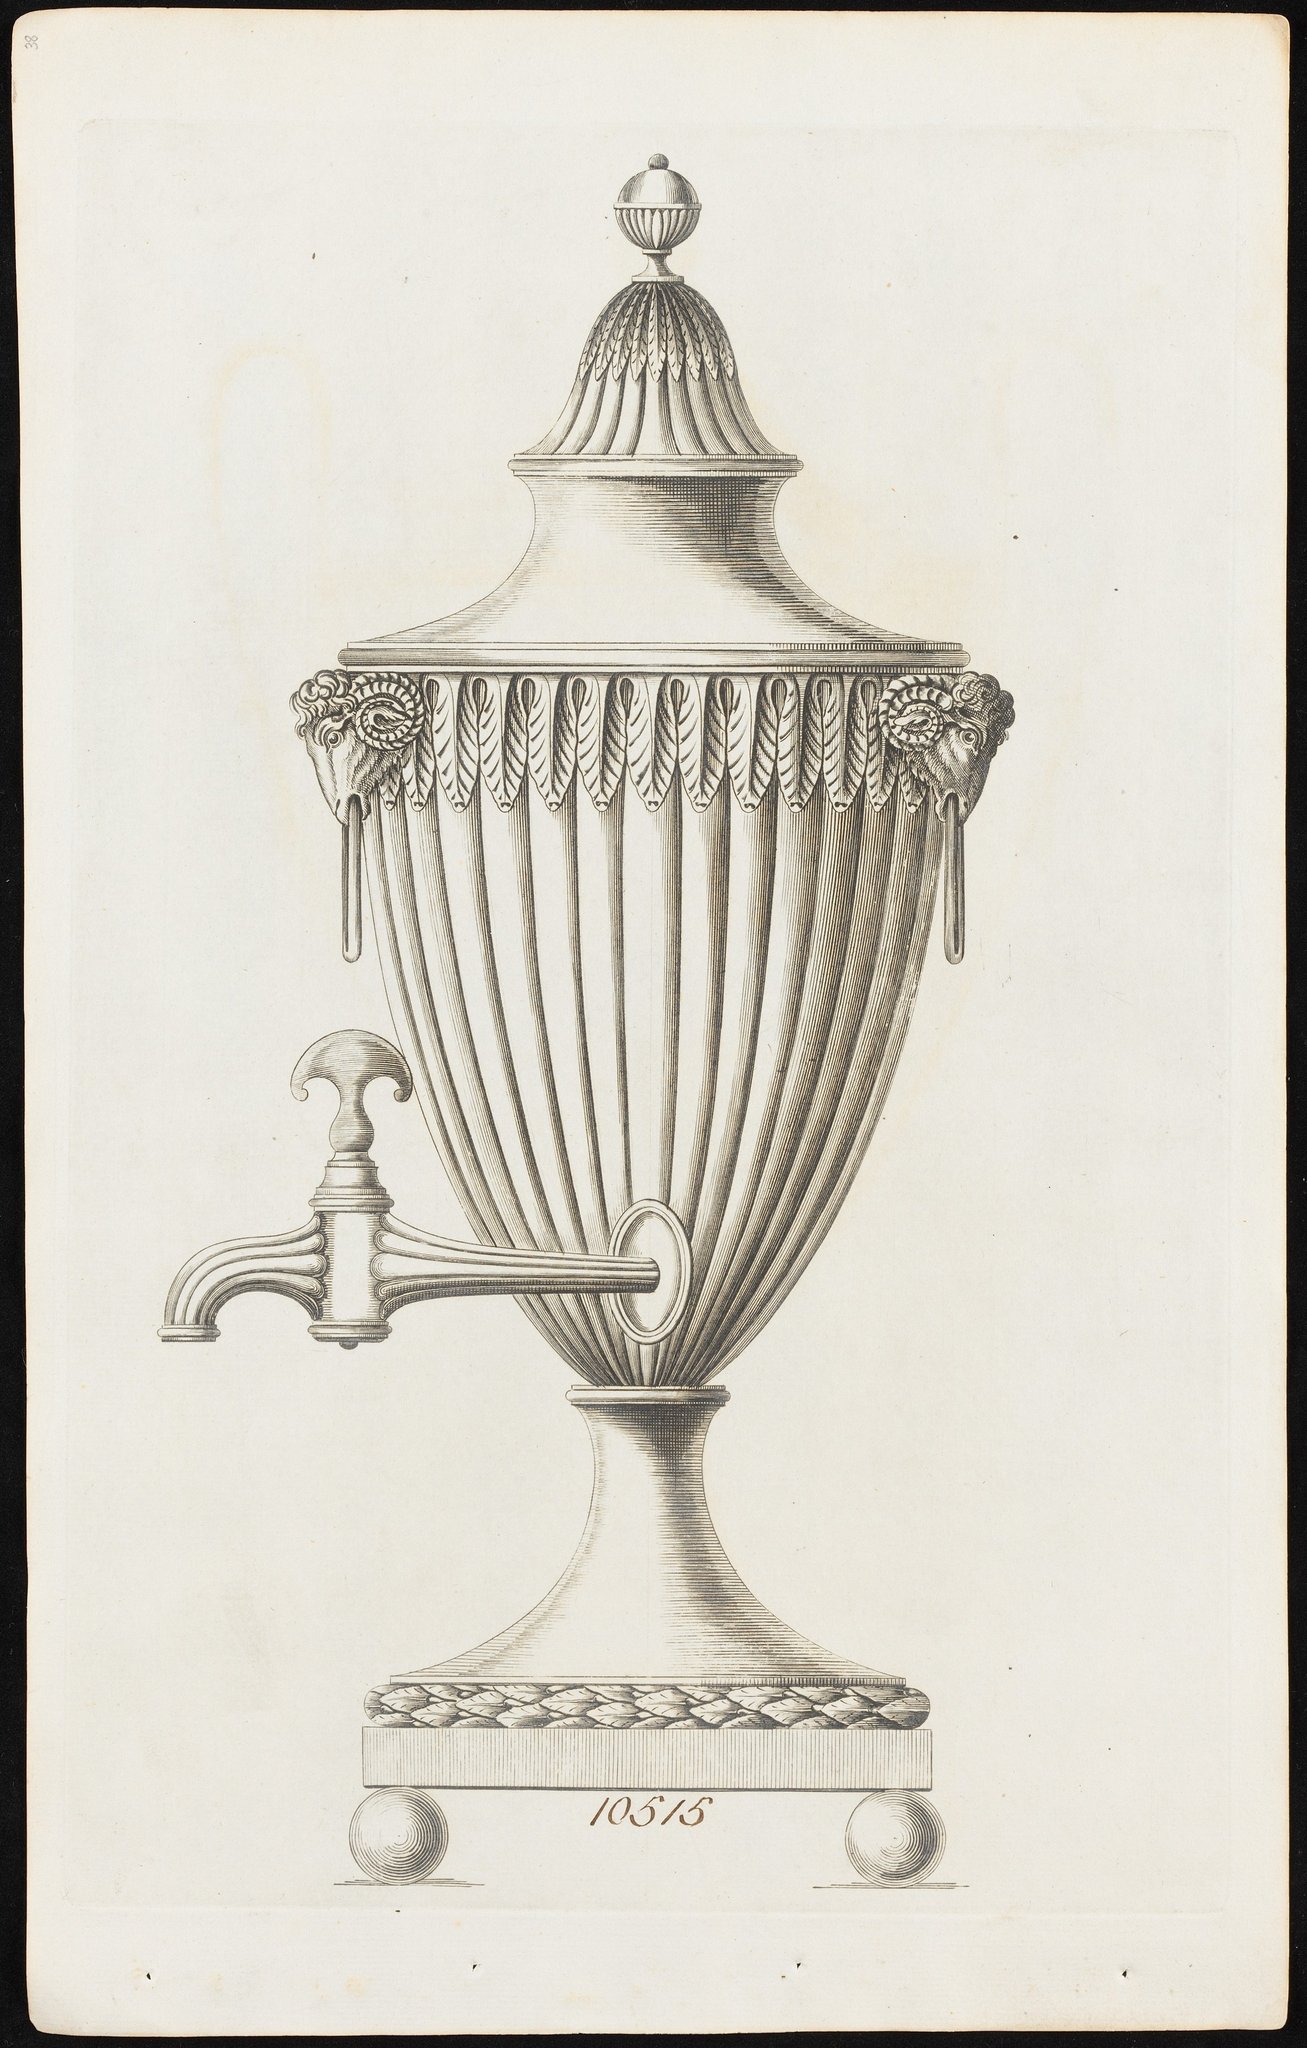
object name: print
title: Hot Water Urn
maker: matthew boulton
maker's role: artist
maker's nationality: british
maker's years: 1728-1809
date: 1790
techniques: etching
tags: urns